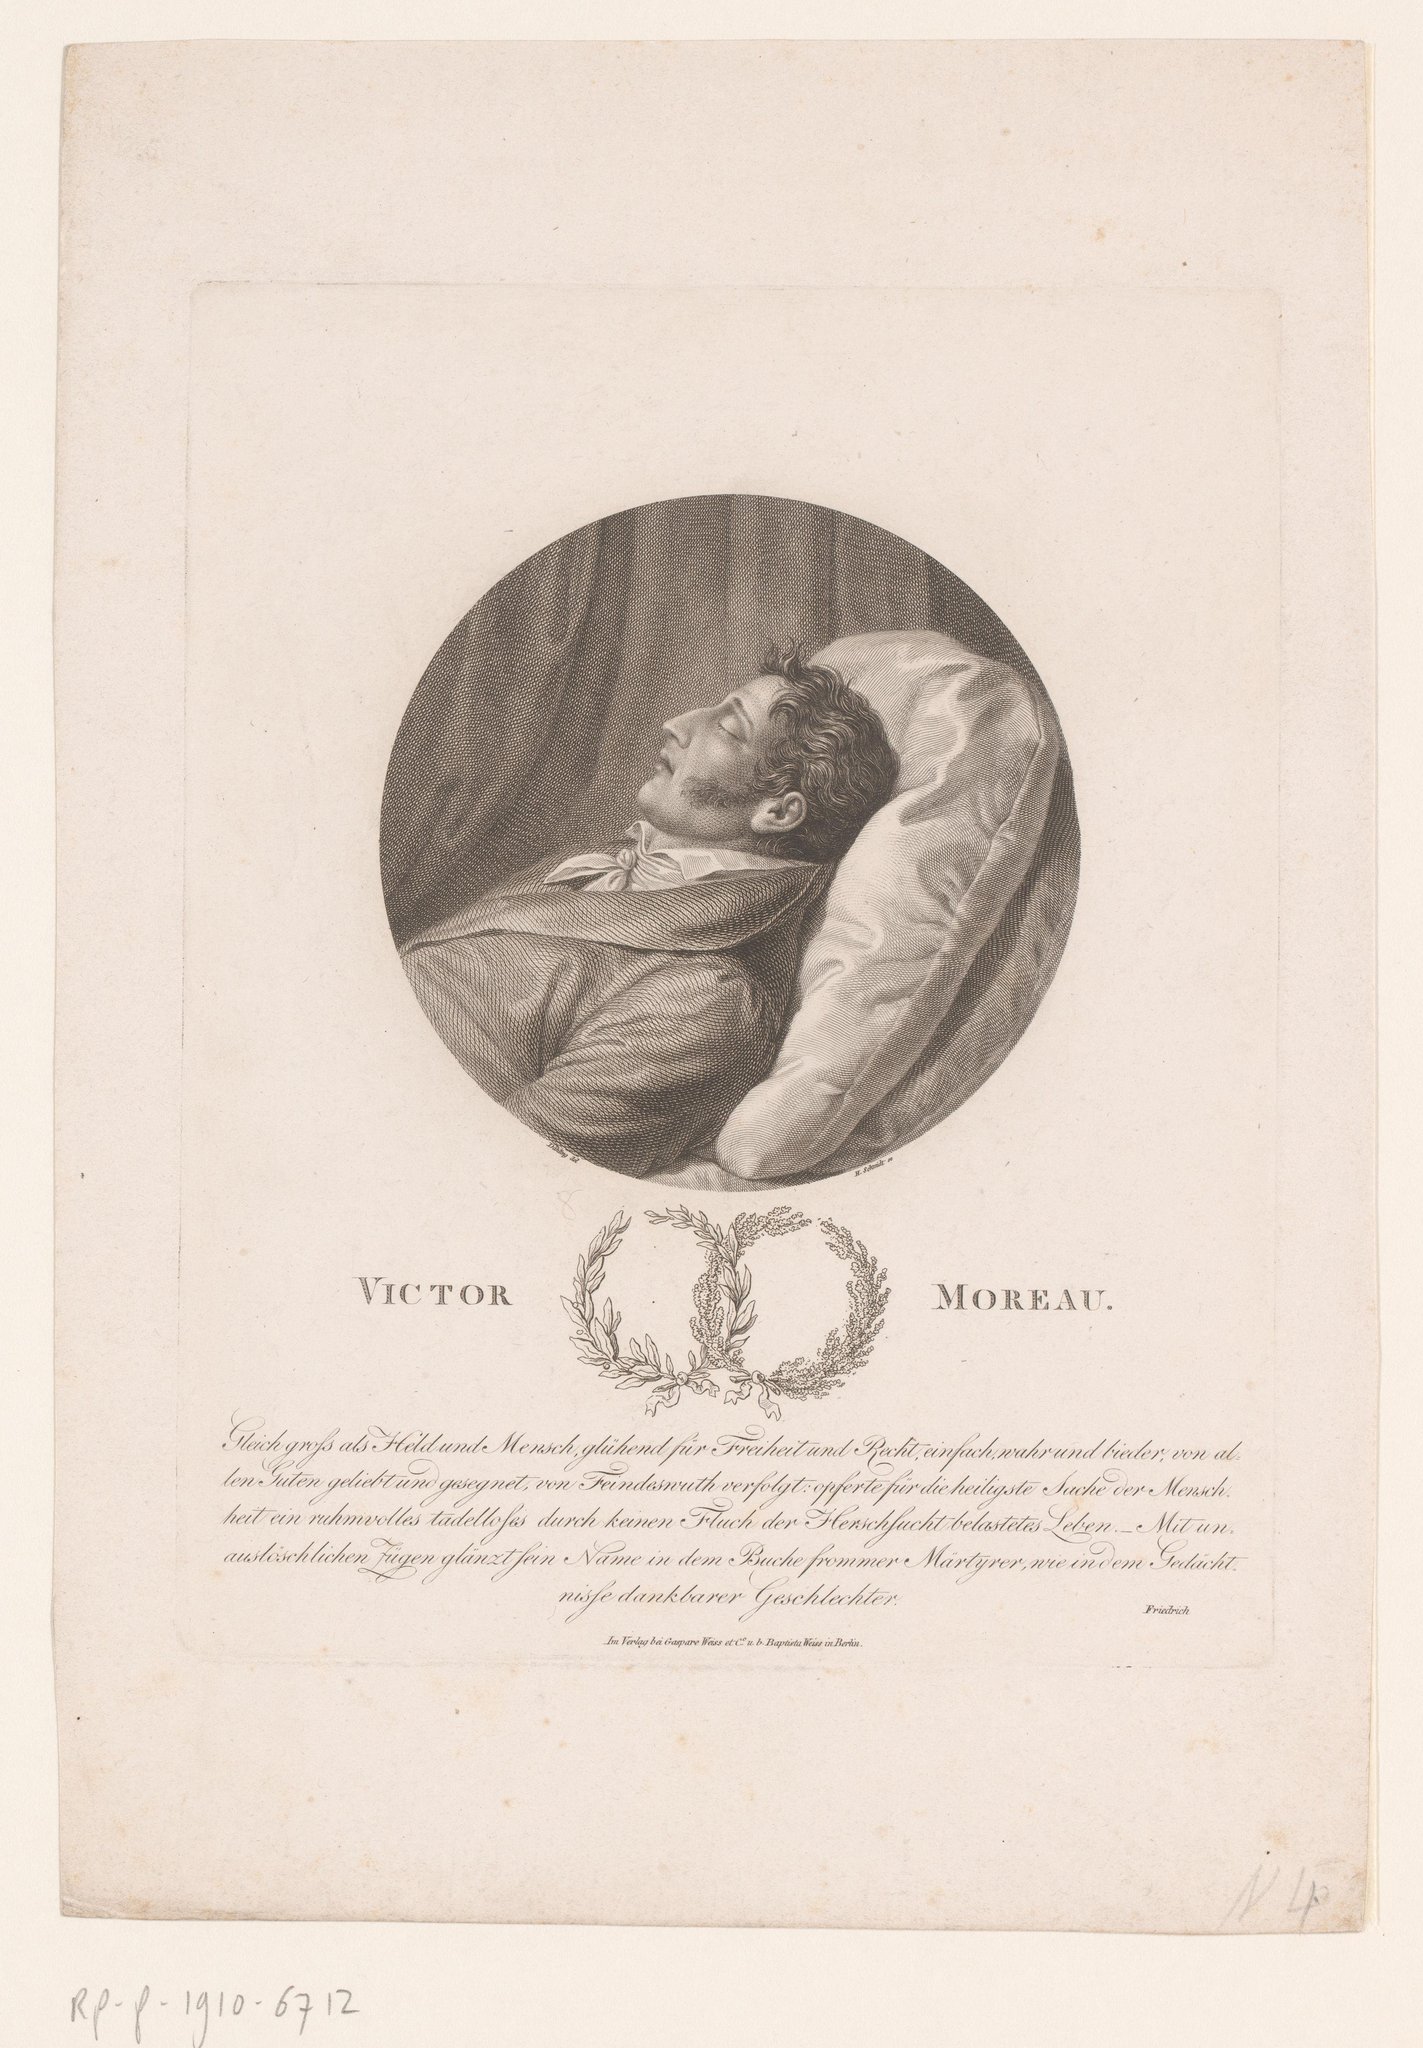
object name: print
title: Portret van Jean Victor Marie Moreau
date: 1750-1821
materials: paper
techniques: engraving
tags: historical persons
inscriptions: collector's mark: Lugt 2228